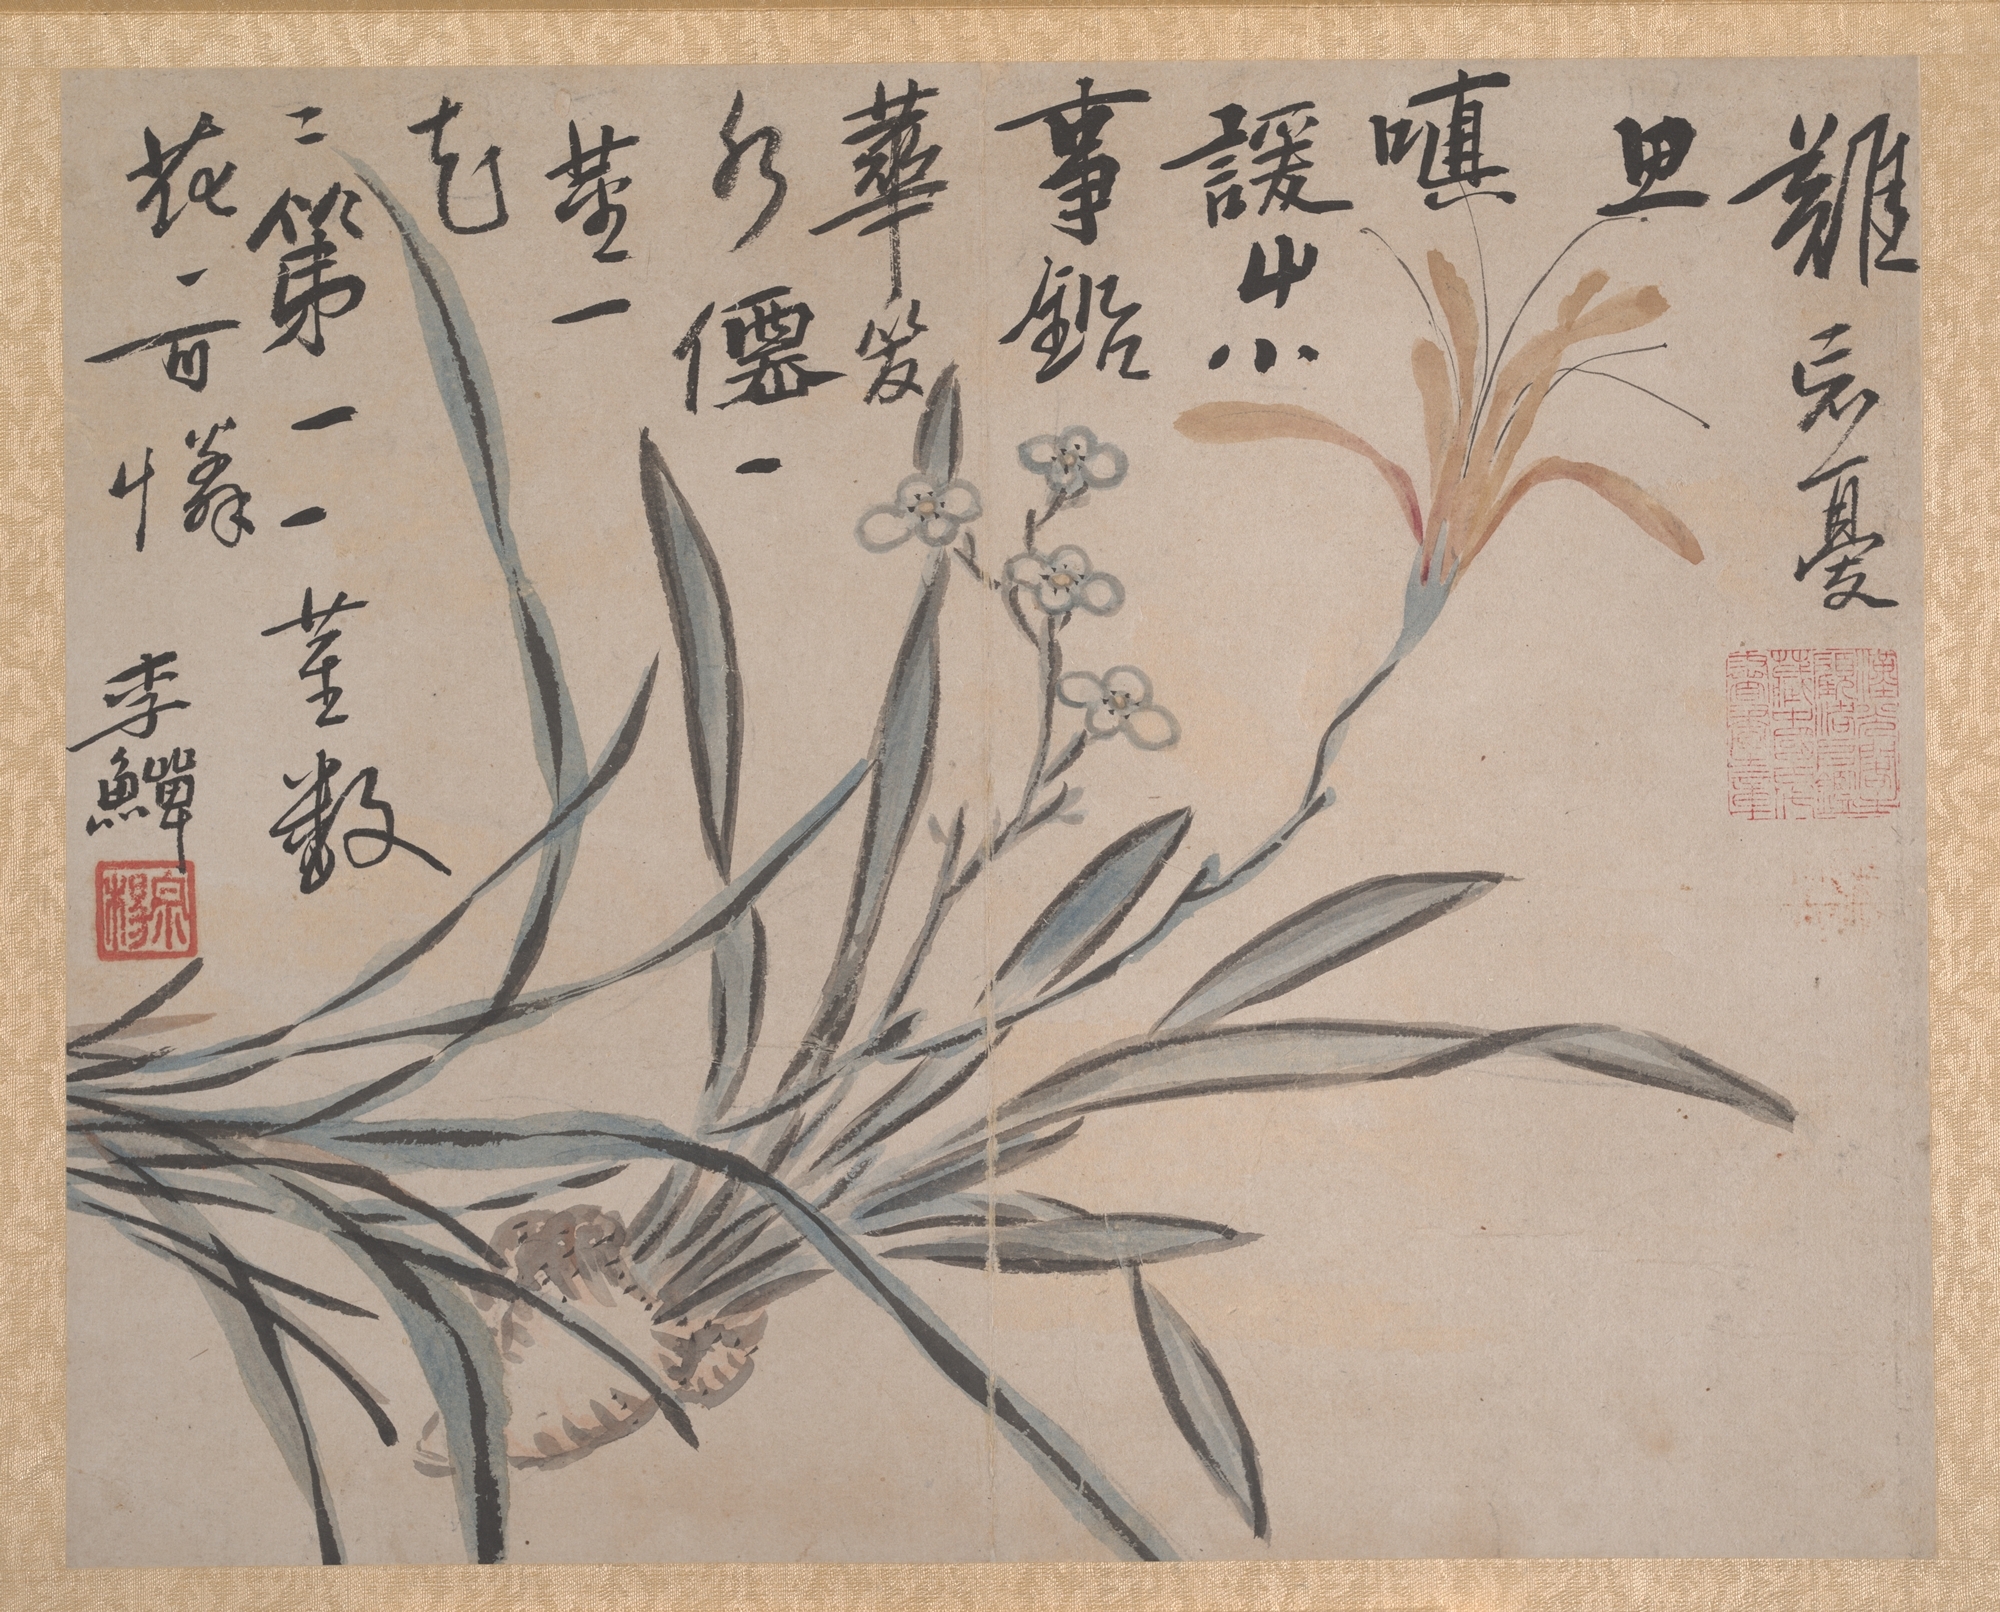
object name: album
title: Plants and Vegetables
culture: chinese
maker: unidentified artist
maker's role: artist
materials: ink, paper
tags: vegetables,plants